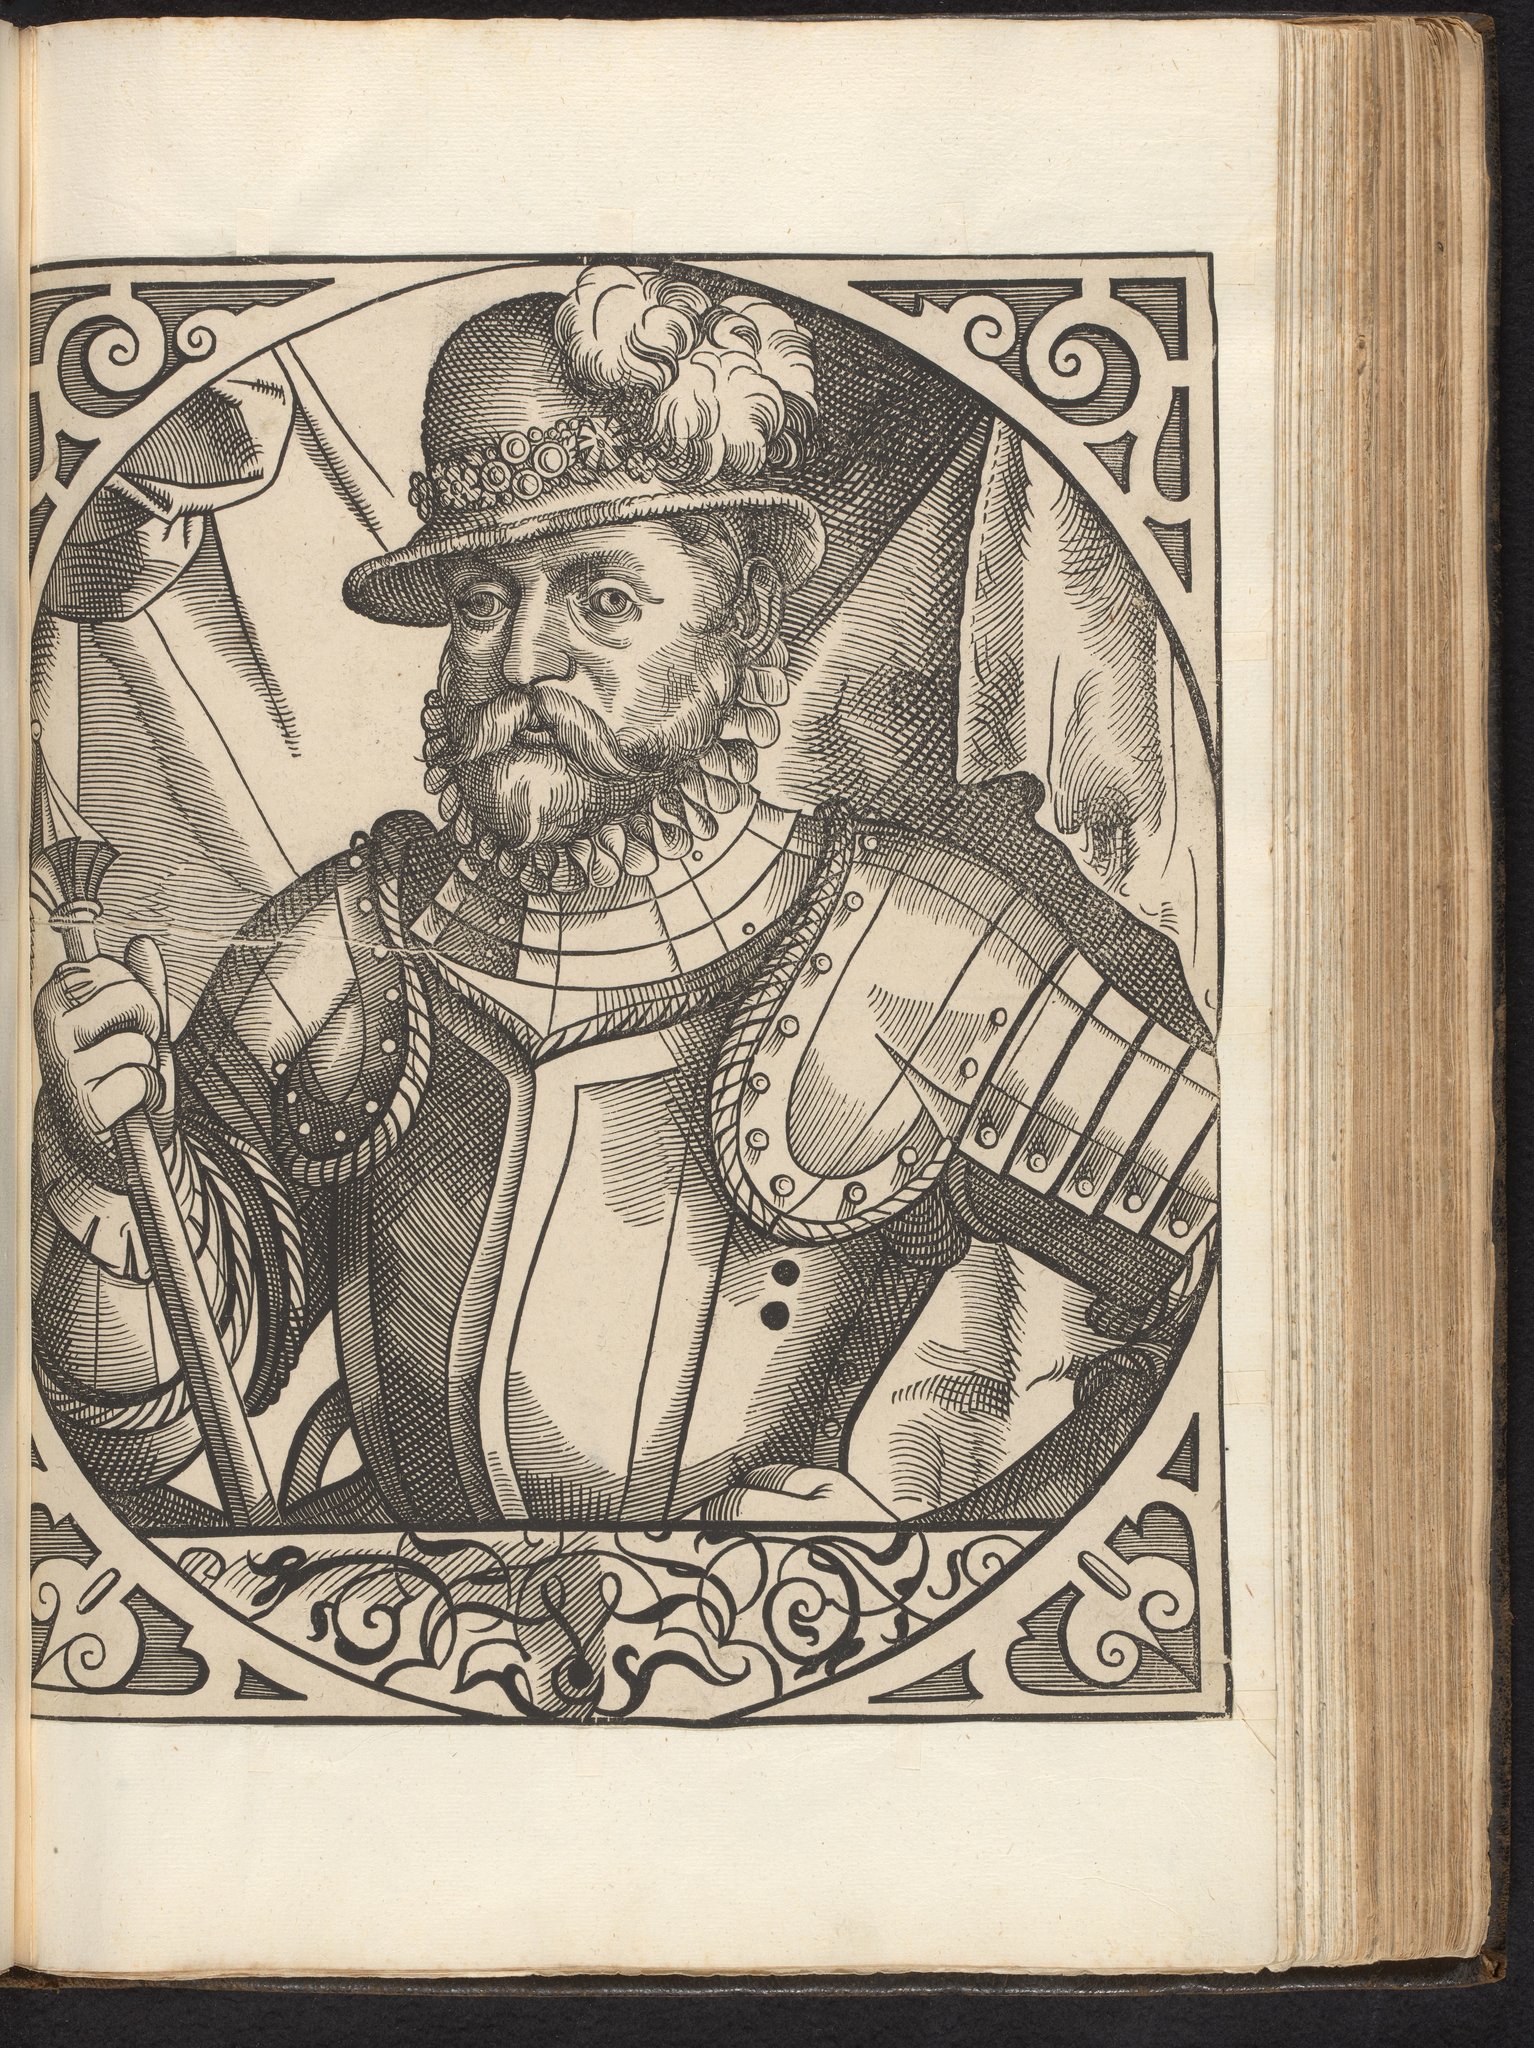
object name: album leaf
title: Portret van Johan Casimir van Palts-Lautern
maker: Anonymous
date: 1560-1592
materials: paper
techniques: woodcut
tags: historical persons